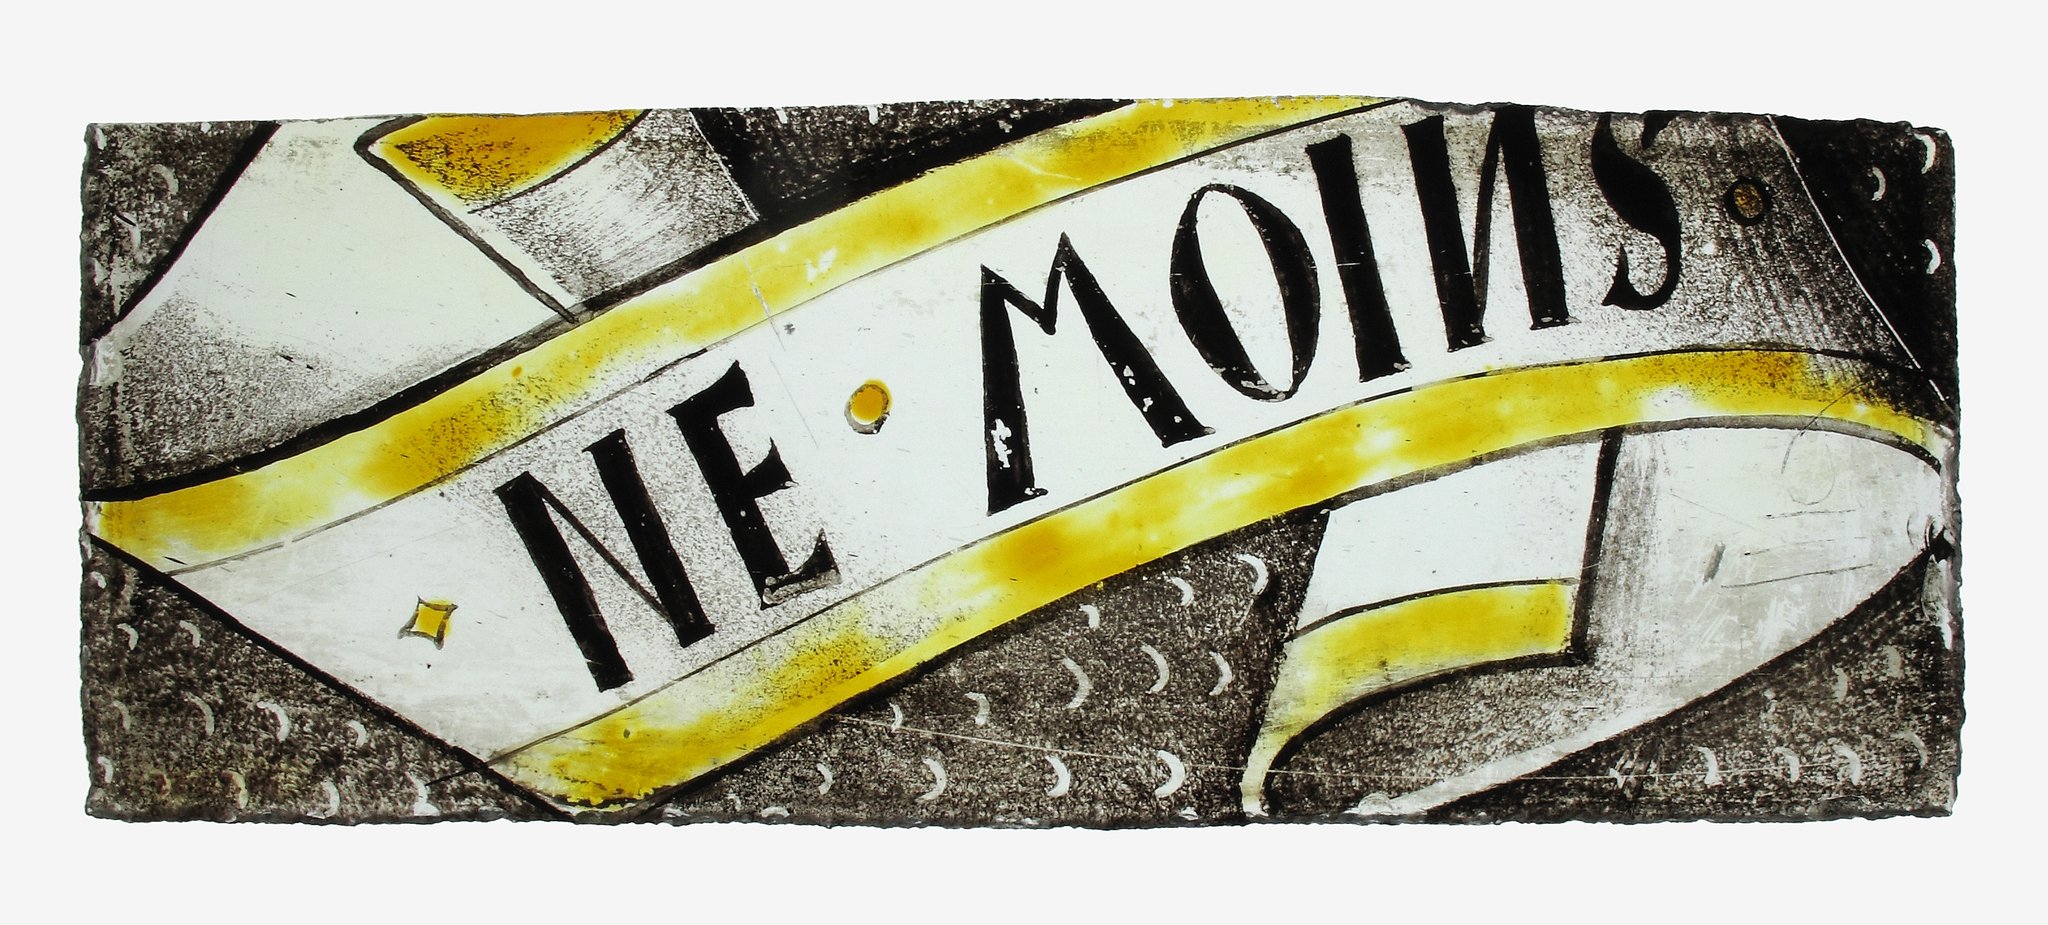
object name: fragment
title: Glass Fragment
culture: european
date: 1401-1500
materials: glass